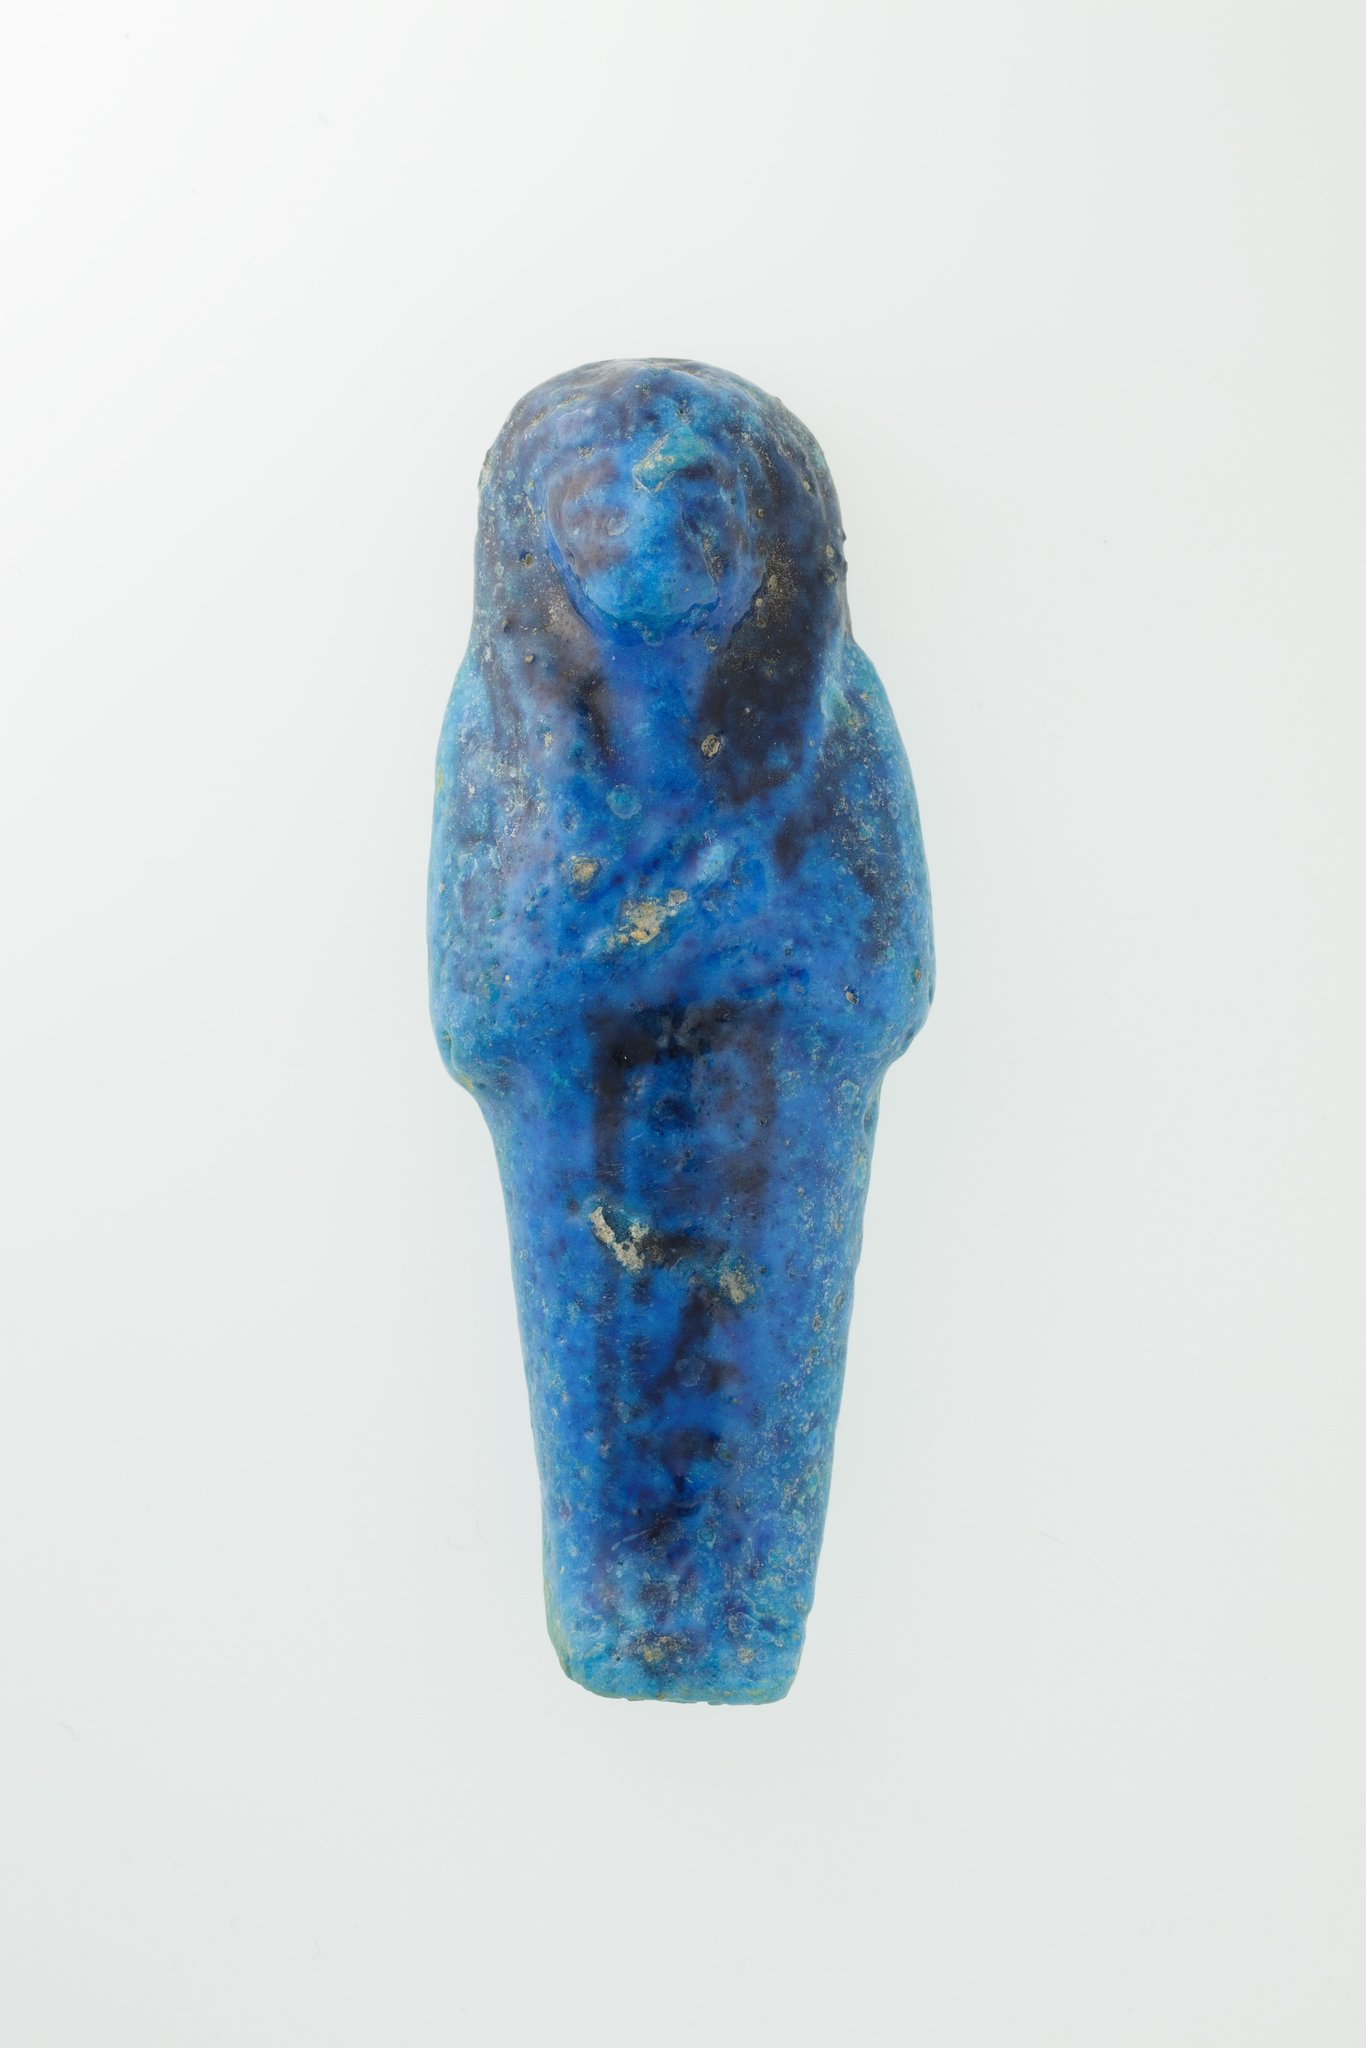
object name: shabti, worker, nauny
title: Worker Shabti of Nauny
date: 1050 BCE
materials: faience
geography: egypt